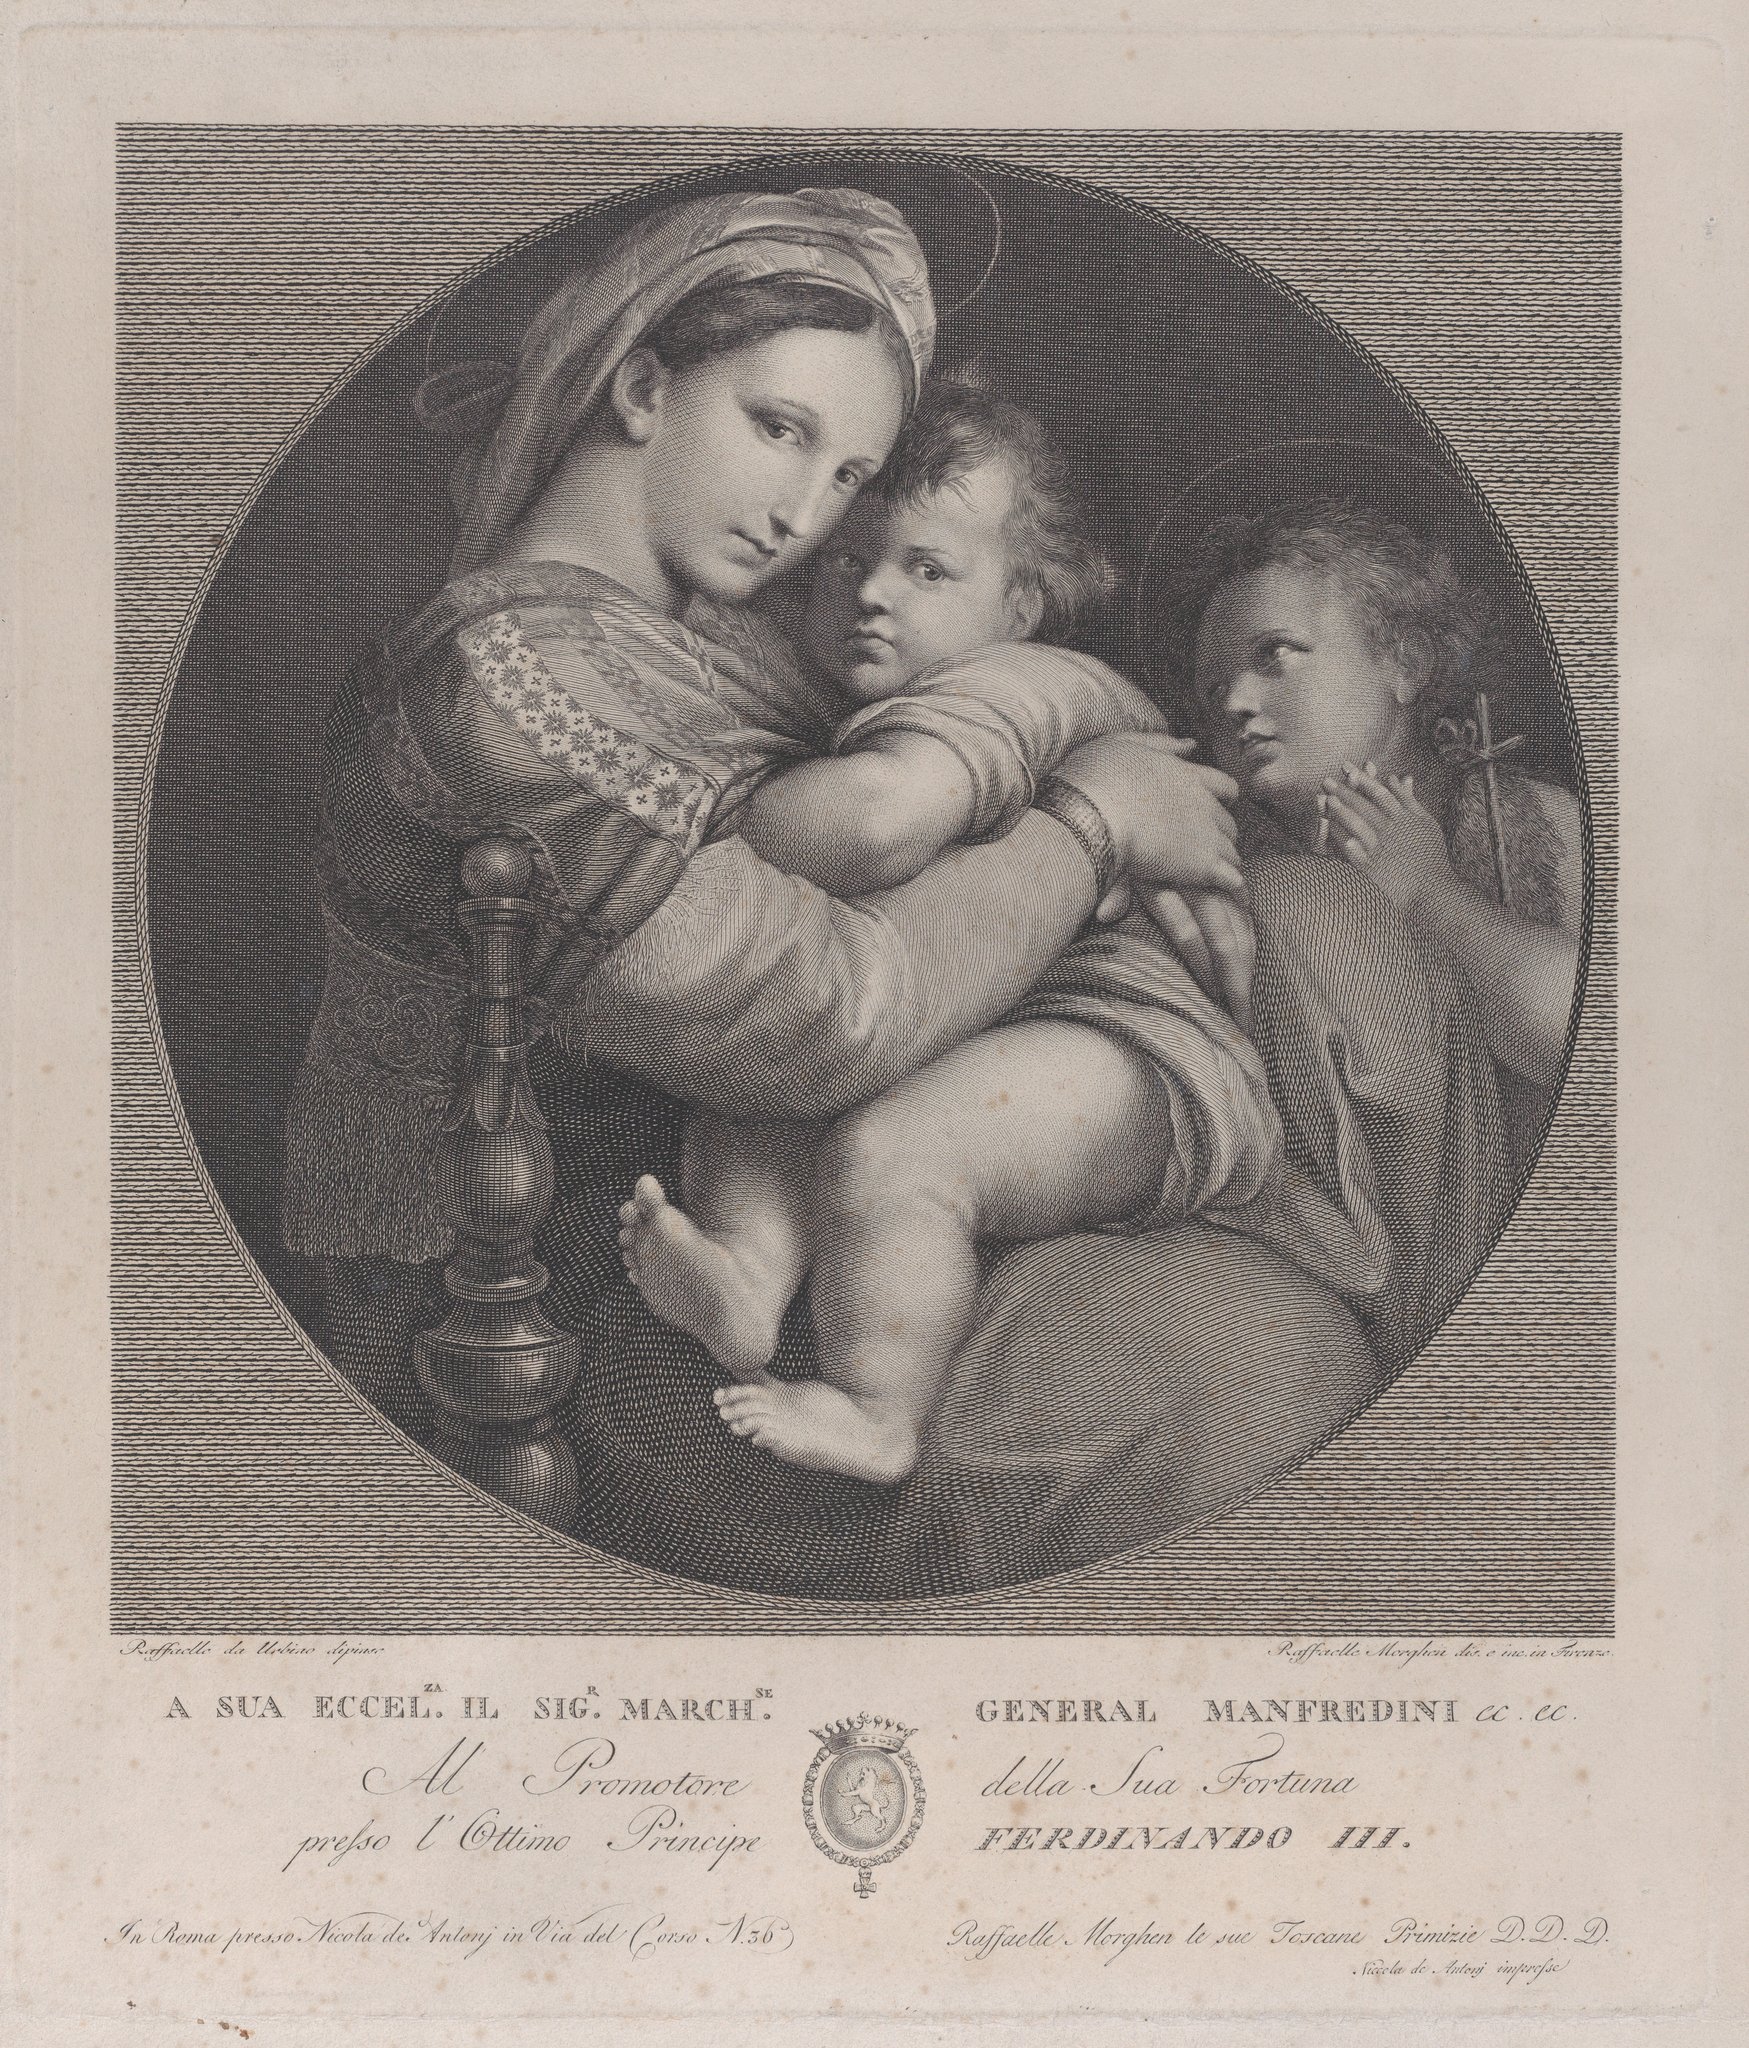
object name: print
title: Madonna of the chair (Madonna della Seggiola)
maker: raphael morghen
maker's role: artist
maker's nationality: italian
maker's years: 1758-1833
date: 1793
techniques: engraving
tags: saint john the baptist,virgin mary,jesus